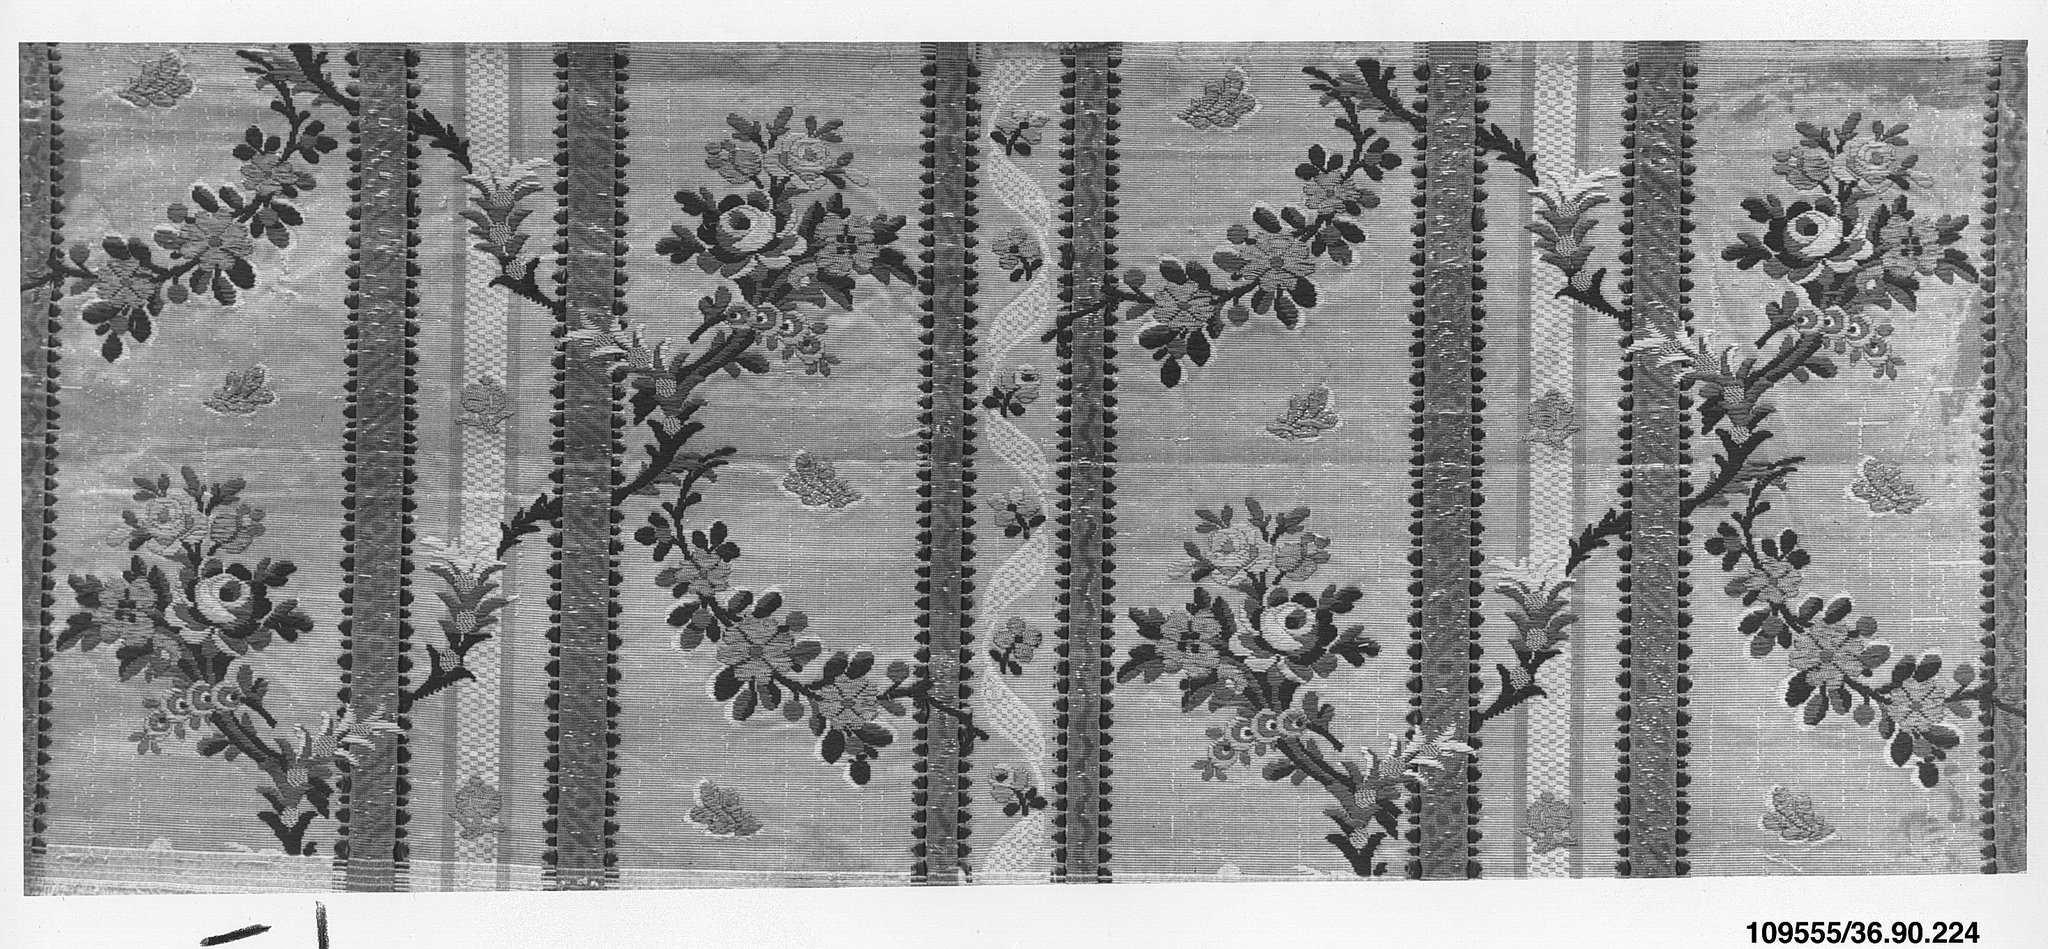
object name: piece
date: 1701-1800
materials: metal thread, silk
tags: flowers,leaves